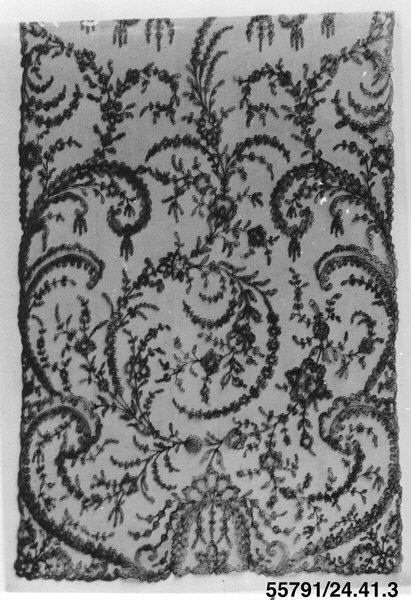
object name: scarf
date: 1801-1900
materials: silk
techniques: lace